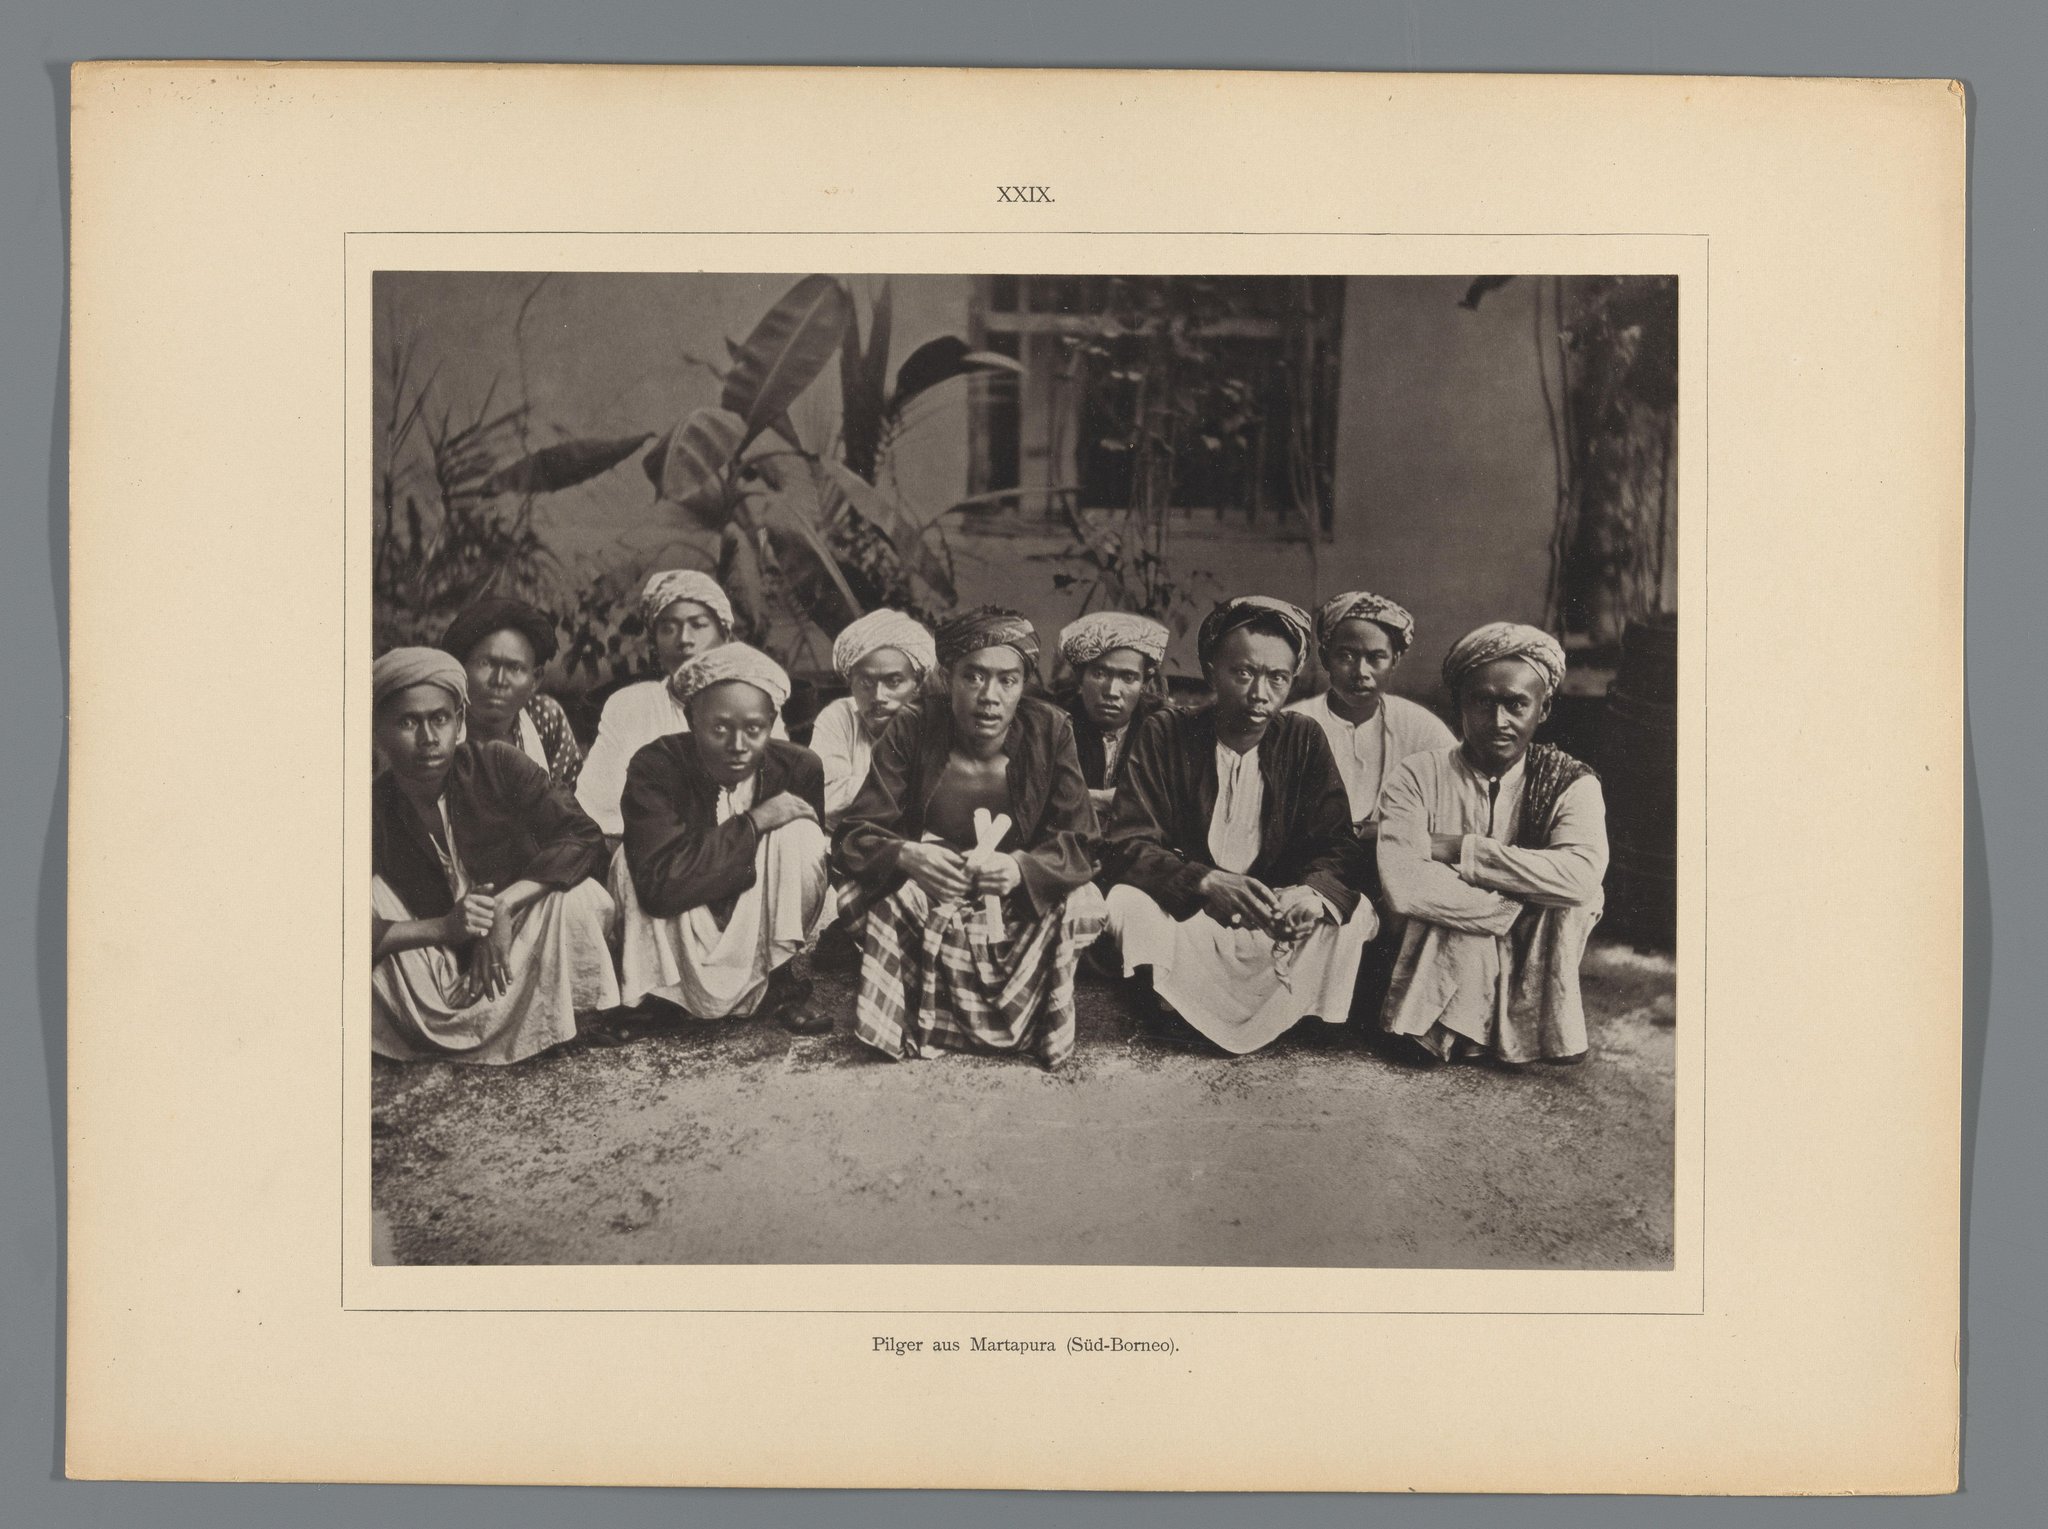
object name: page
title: Nederlands-Indische pelgrims uit Martapura, te Djedda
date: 1884-1888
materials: paper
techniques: photograph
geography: djedda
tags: the believer ~ islam, mohammedanism, anonymous historical persons portrayed in a group, in a group-portrait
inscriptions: number: ‘XXIX.’